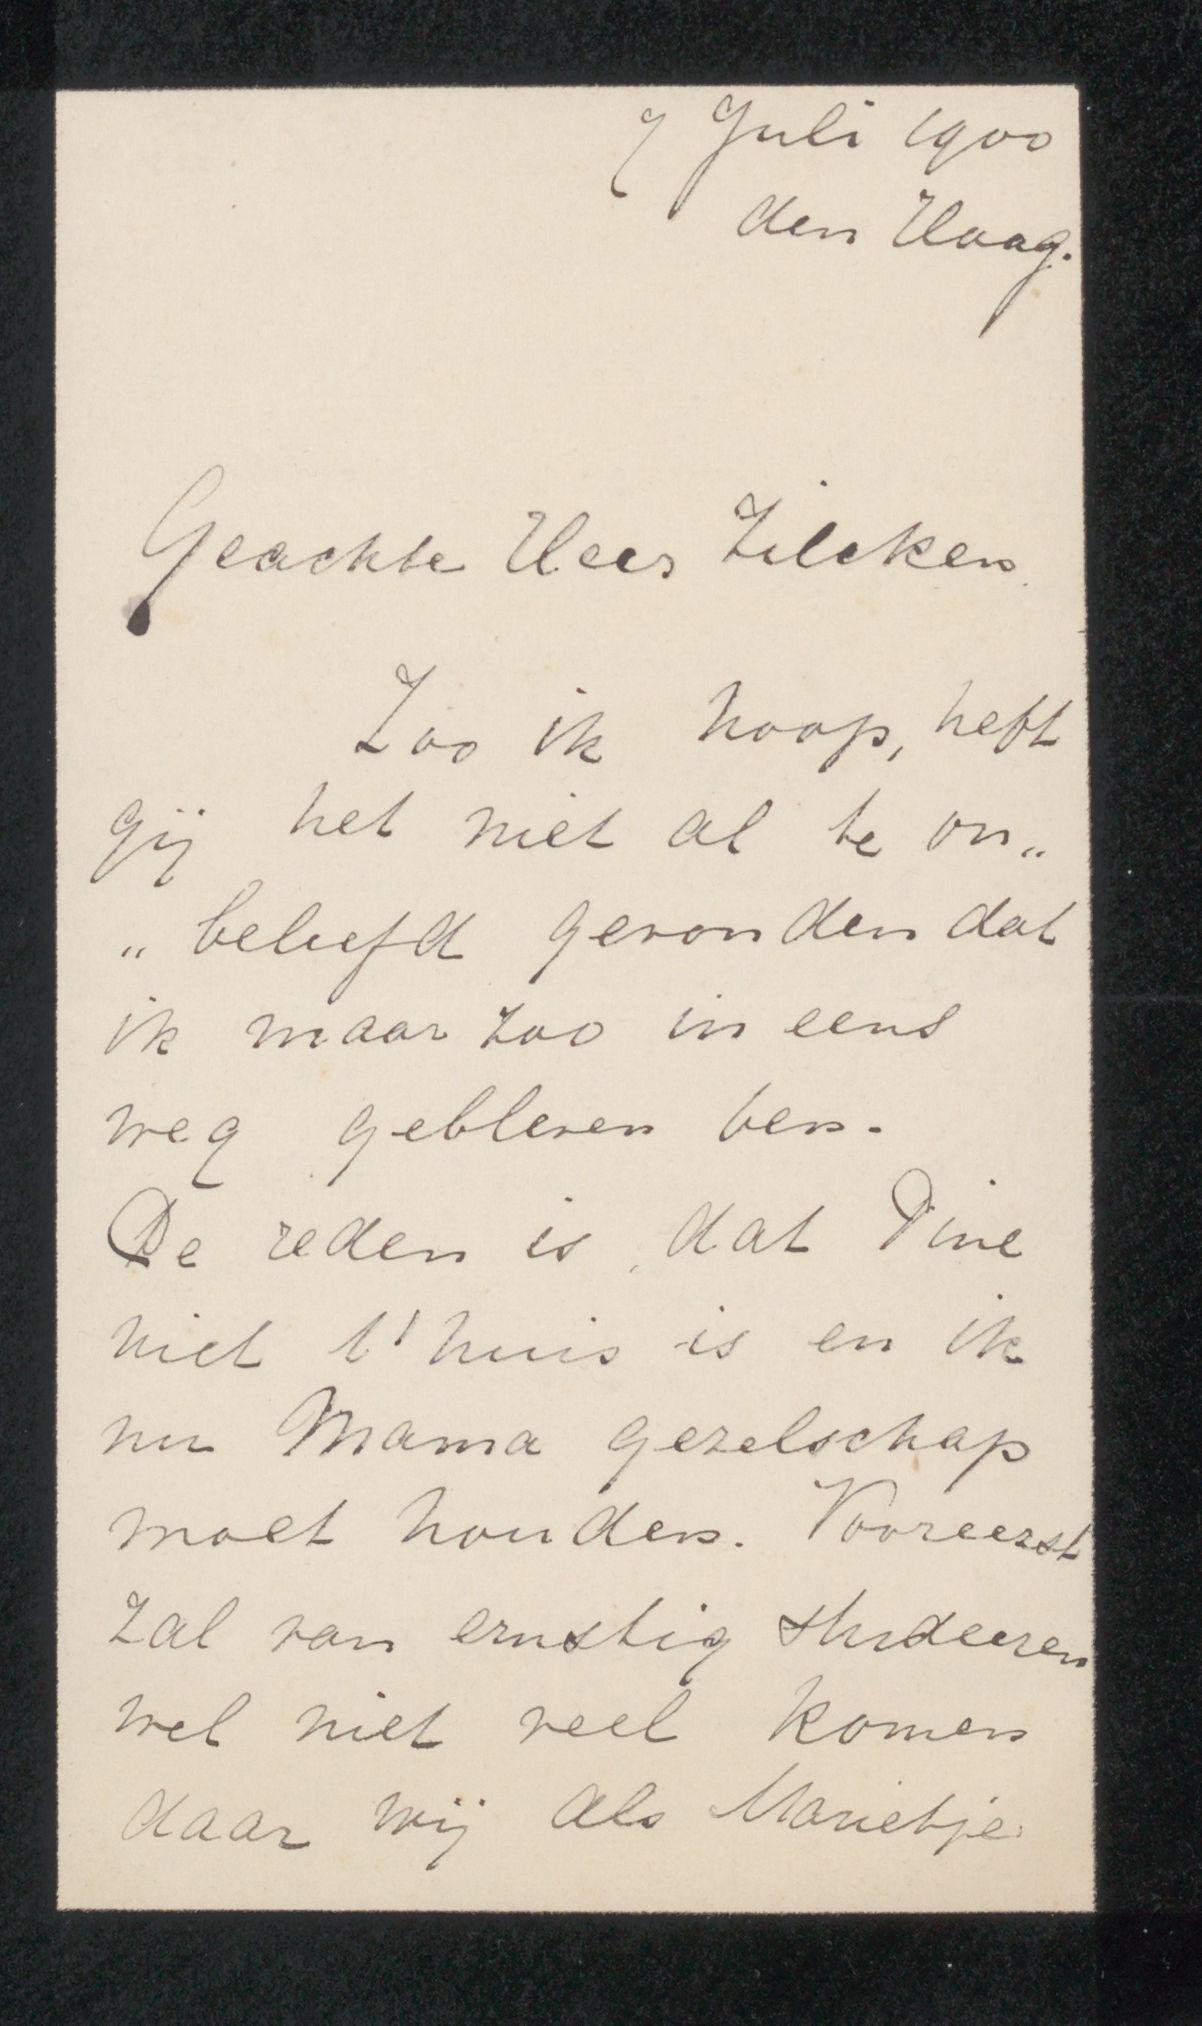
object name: letter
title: Brief aan Philip Zilcken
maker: annie maris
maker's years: 1875-1944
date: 1900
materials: ink, paper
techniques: pen, writing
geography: the hague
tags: painter, draughtsman, philip zilcken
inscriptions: collector's mark: ‘RPK’